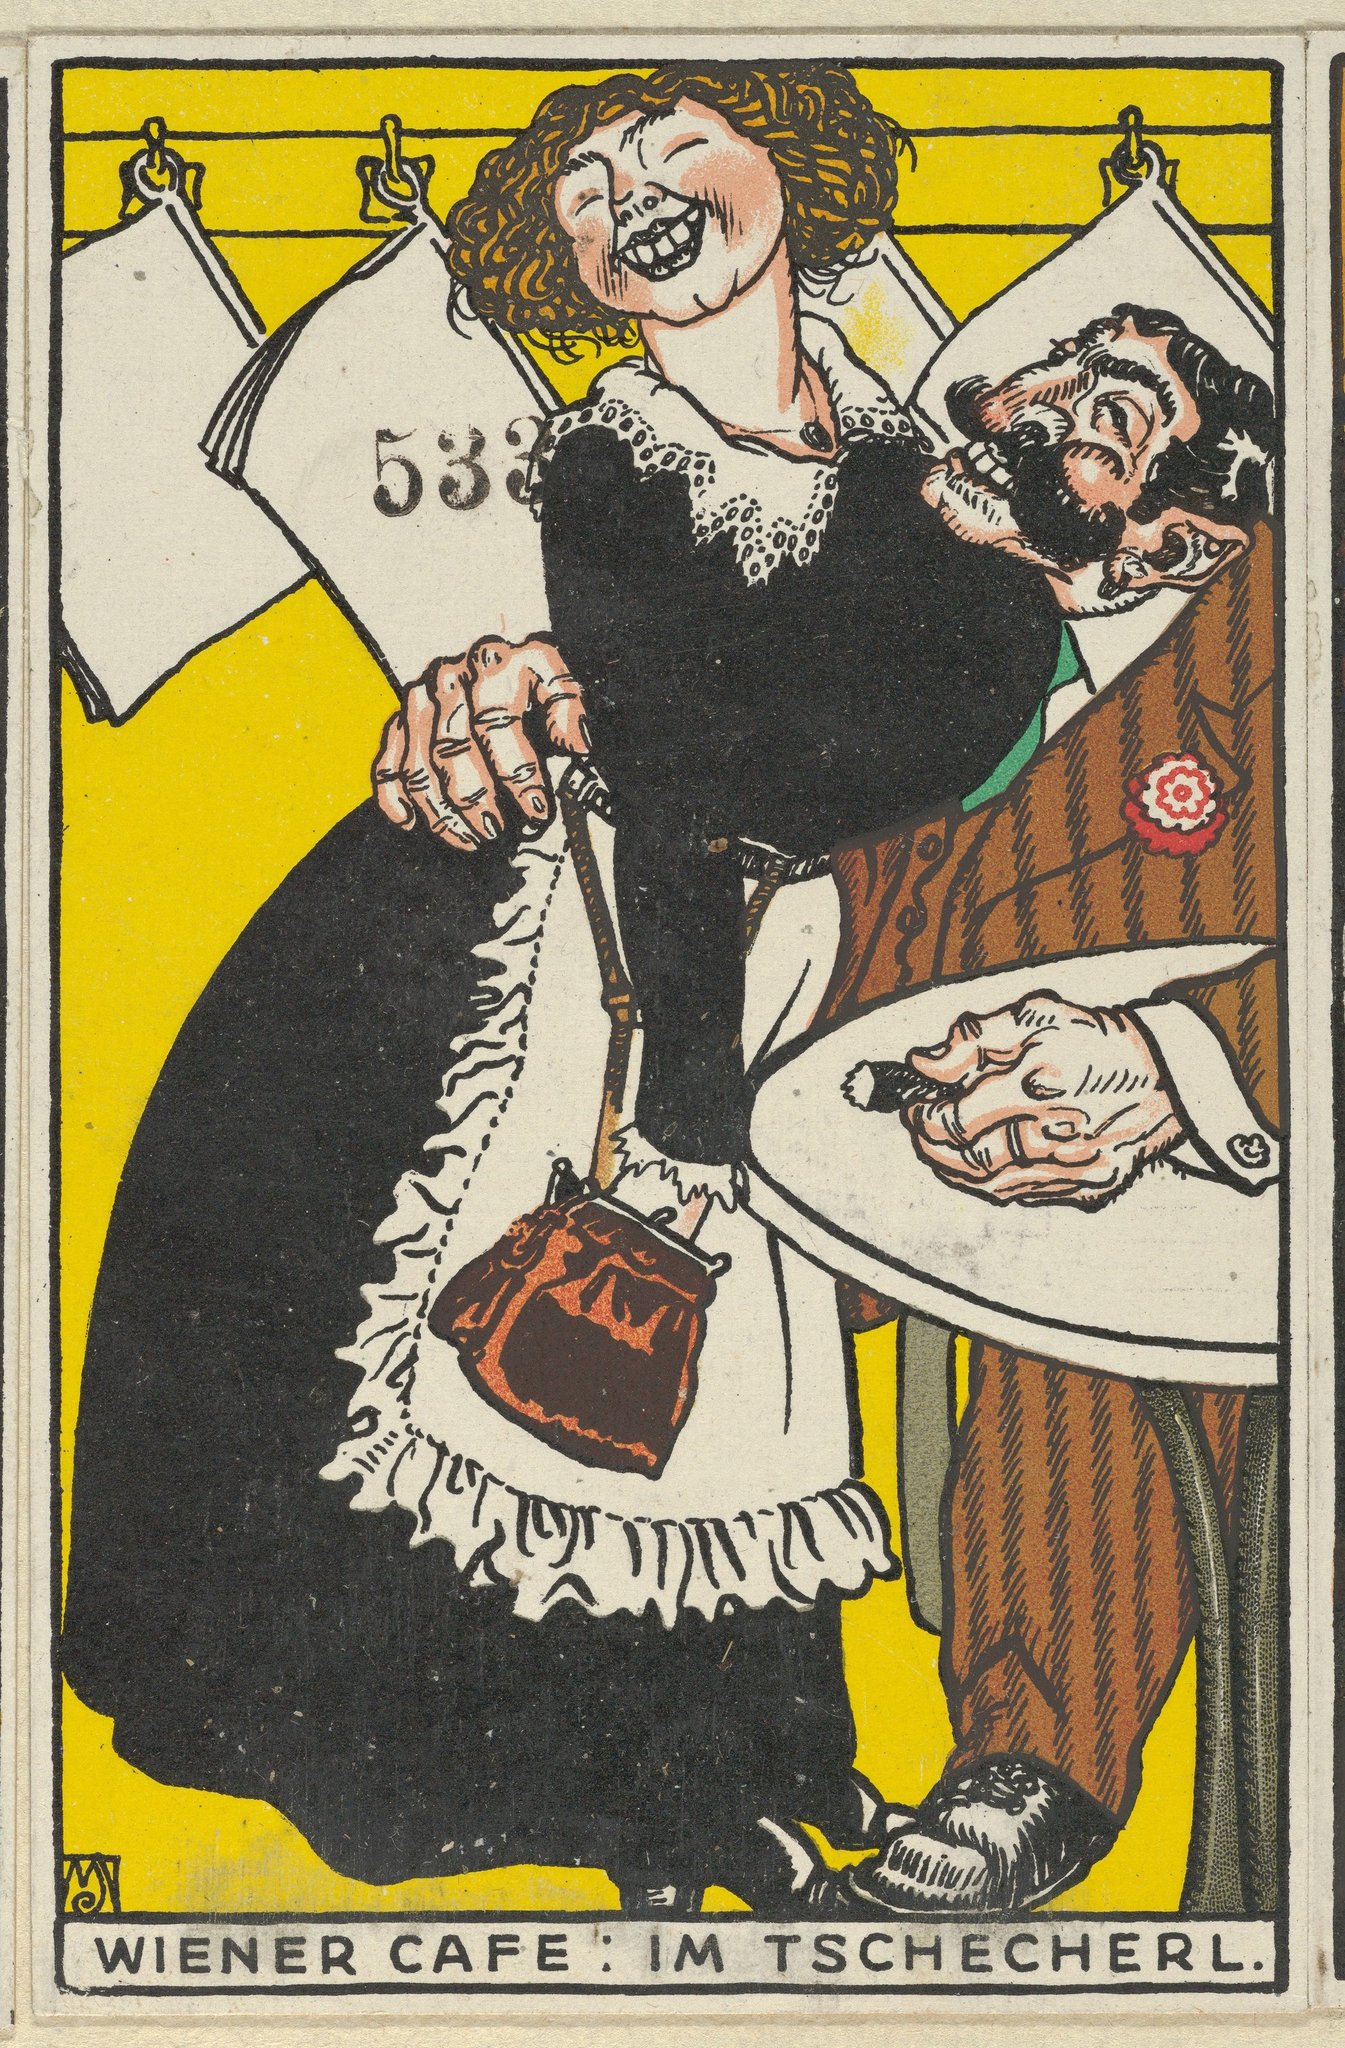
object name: print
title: Viennese Café: In the Little Café (Wiener Café: Im Tschecherl)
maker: moriz jung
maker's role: artist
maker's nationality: austrian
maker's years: 1885-1915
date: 1911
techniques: lithograph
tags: men,women